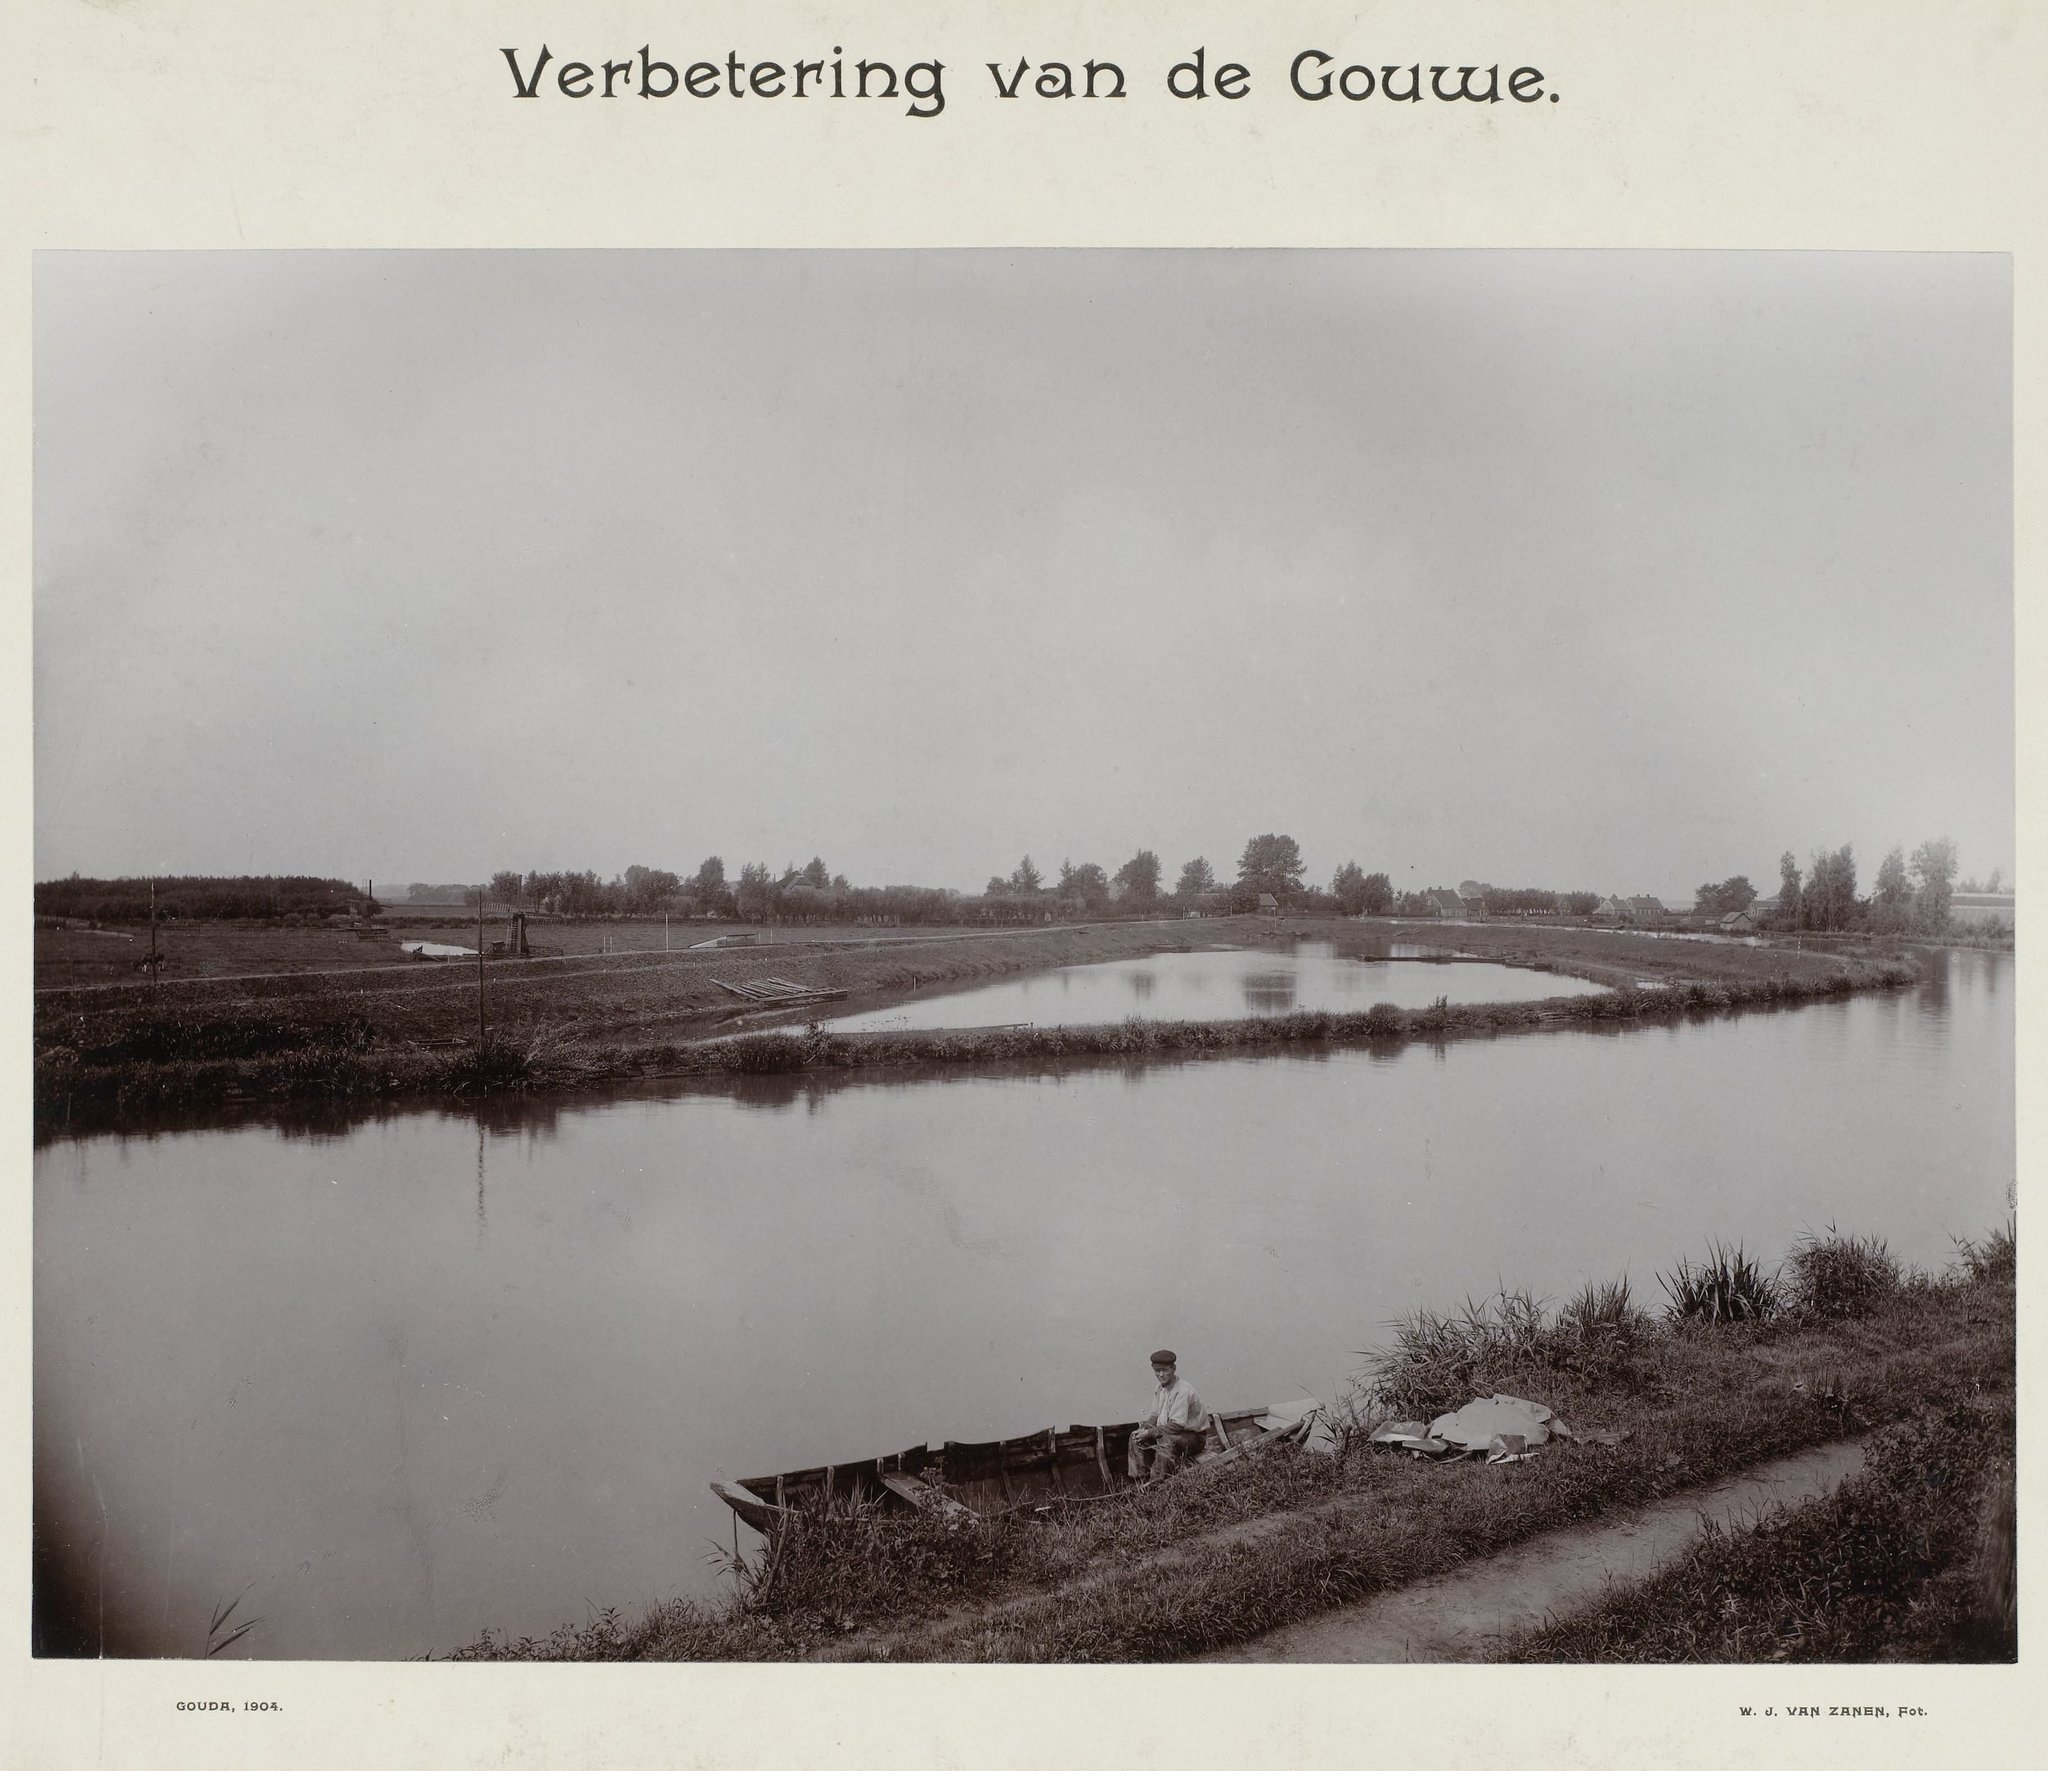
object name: photograph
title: Verbetering van de Gouwe.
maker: weijert jan van zanen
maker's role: fotograaf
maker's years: 1873-1960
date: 1904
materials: cardboard, paper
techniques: photography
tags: gouda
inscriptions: date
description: Foto op karton van waterbouwkundige werken (verbeteringen die in 1904 aan de Gouwe te Gouda zijn aangebracht). Gedateeerd en gesigneerd.